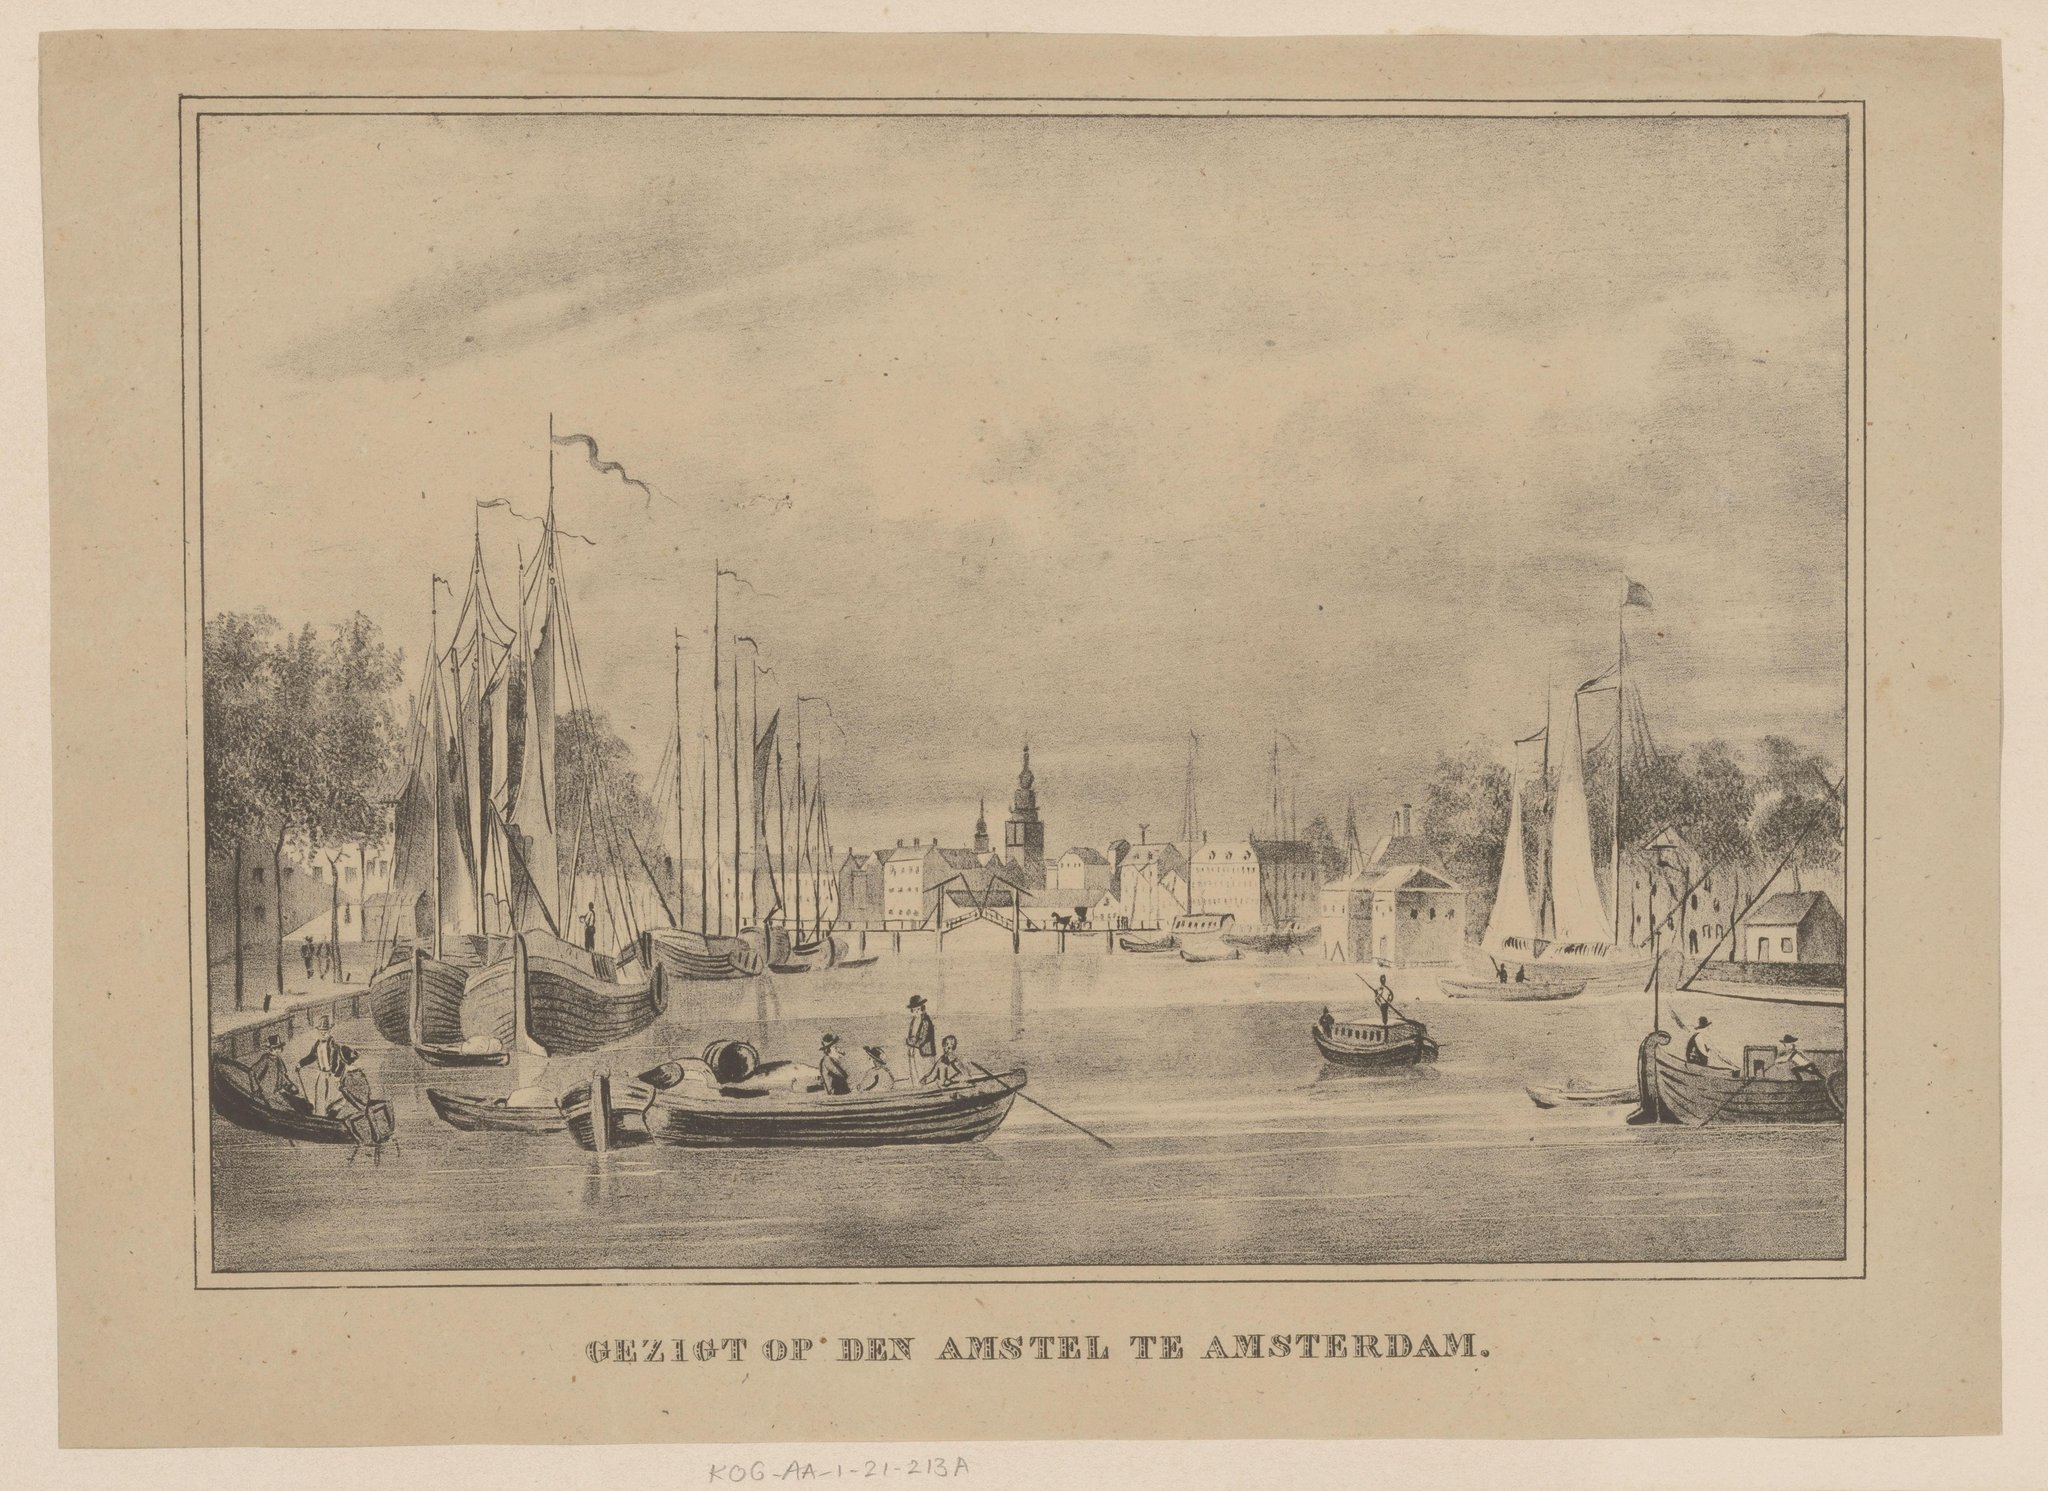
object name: print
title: Gezigt op den Amstel te Amsterdam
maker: Anonymous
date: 1800-1850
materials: paper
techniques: lithograph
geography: netherlands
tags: city-view, and landscape with man-made constructions, sailing-ship, sailing-boat, river, rowing-boat, canoe, etc., bridge in city across river, canal, etc.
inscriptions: collector's mark: Lugt 1641b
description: Onderwerpsrubriek binnen de Atlas Amsterdam: Bestrating, bruggen, wegen.